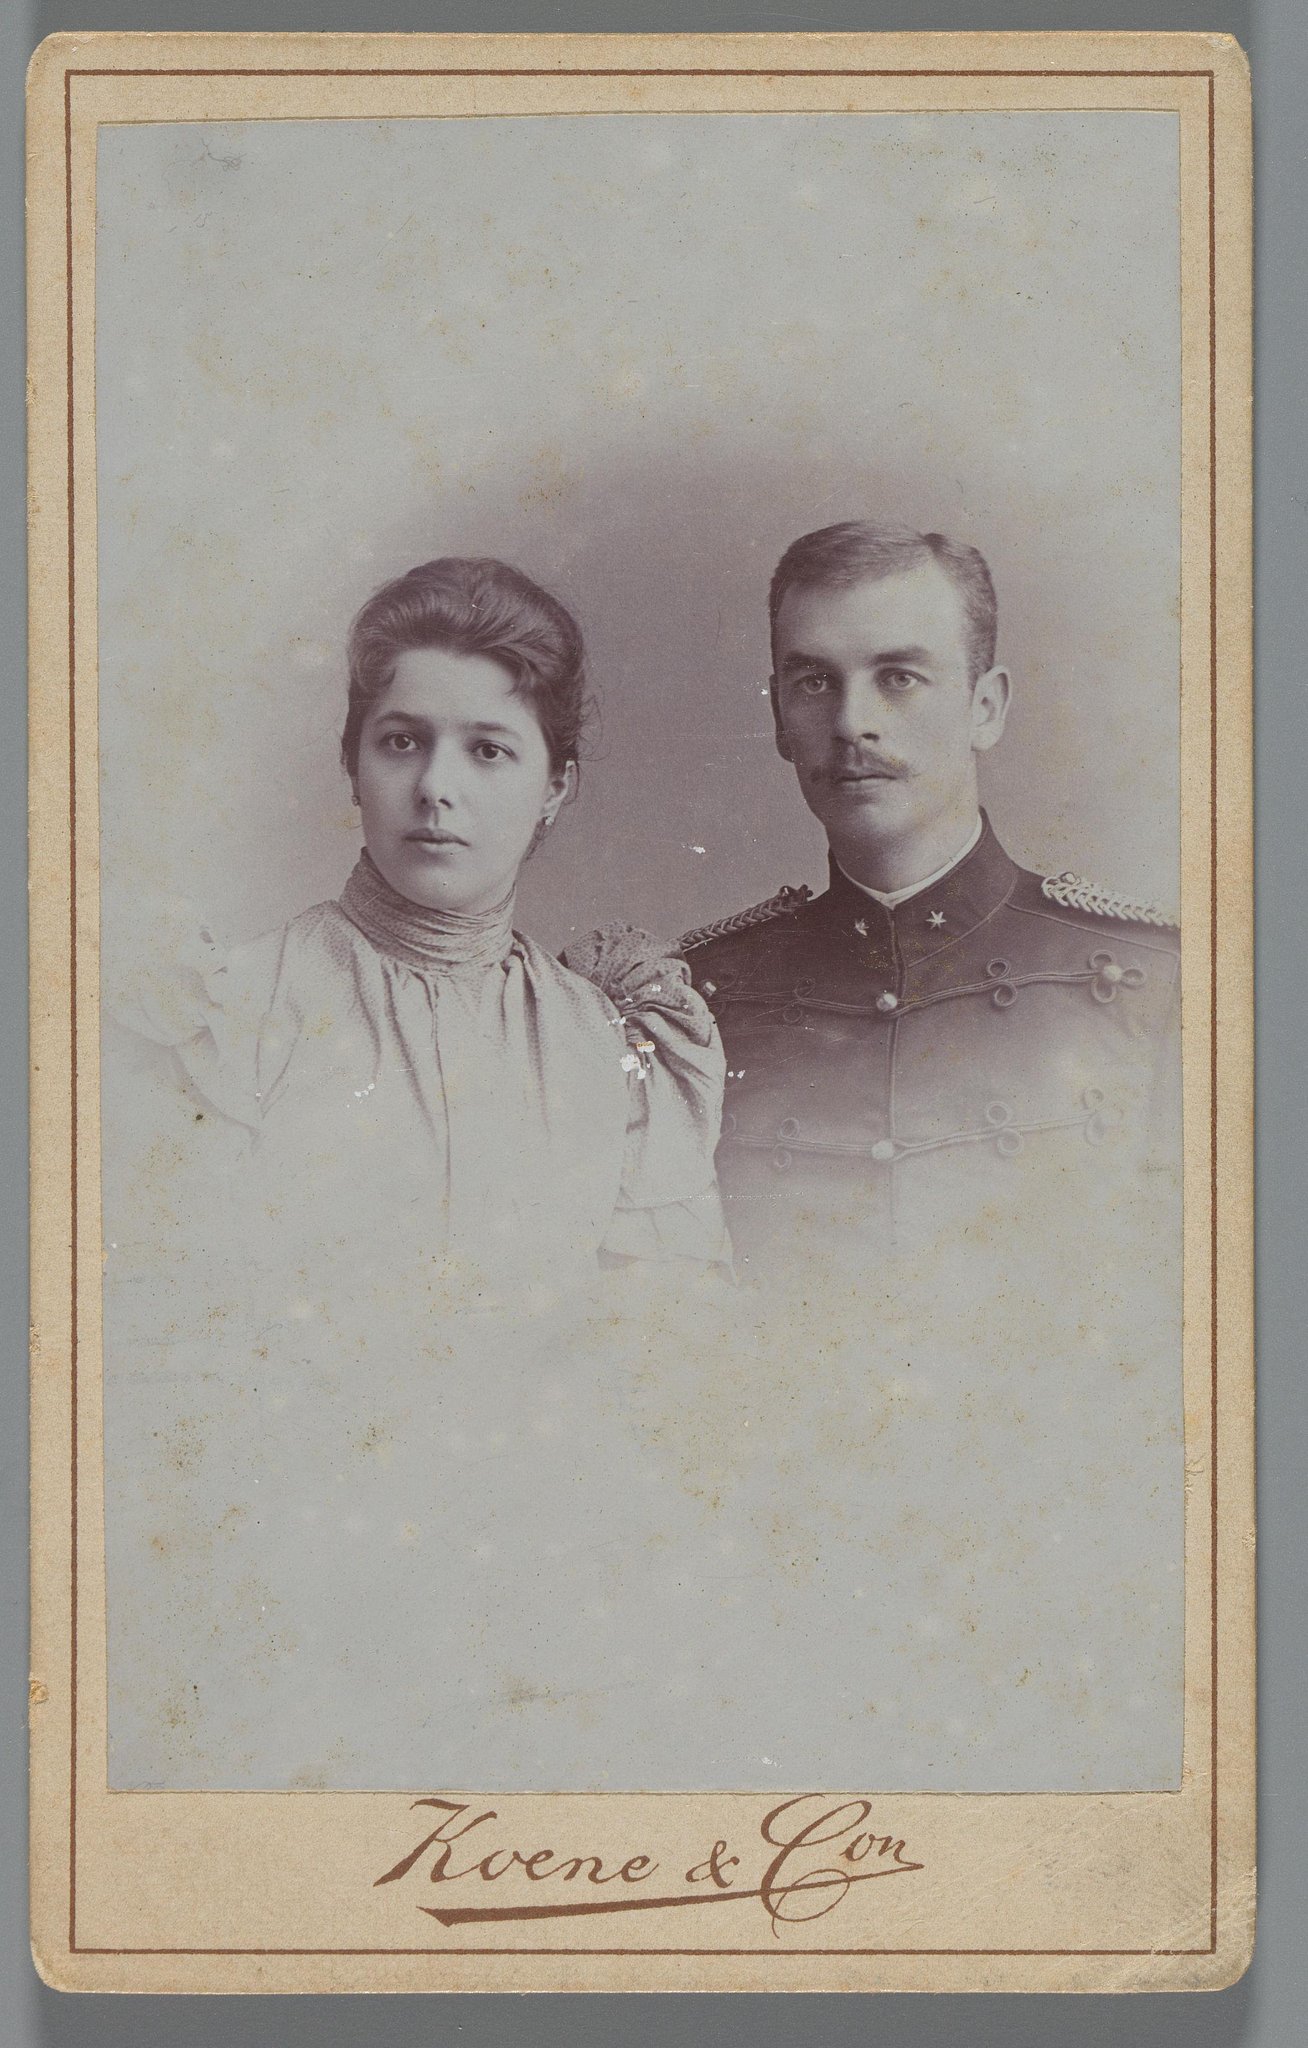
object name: carte de visite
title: Portret van Holle & Lamberts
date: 1860-1910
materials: cardboard, photographic support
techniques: albumen print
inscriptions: date: ‘Lily Holle + / Lamberts’, name: ‘BATAVIA / KOENE & CO / AMSTERDAM / ALKMAAR.’, inscription: ‘Voor Lietje en / ...’, name: ‘Koene & Co’